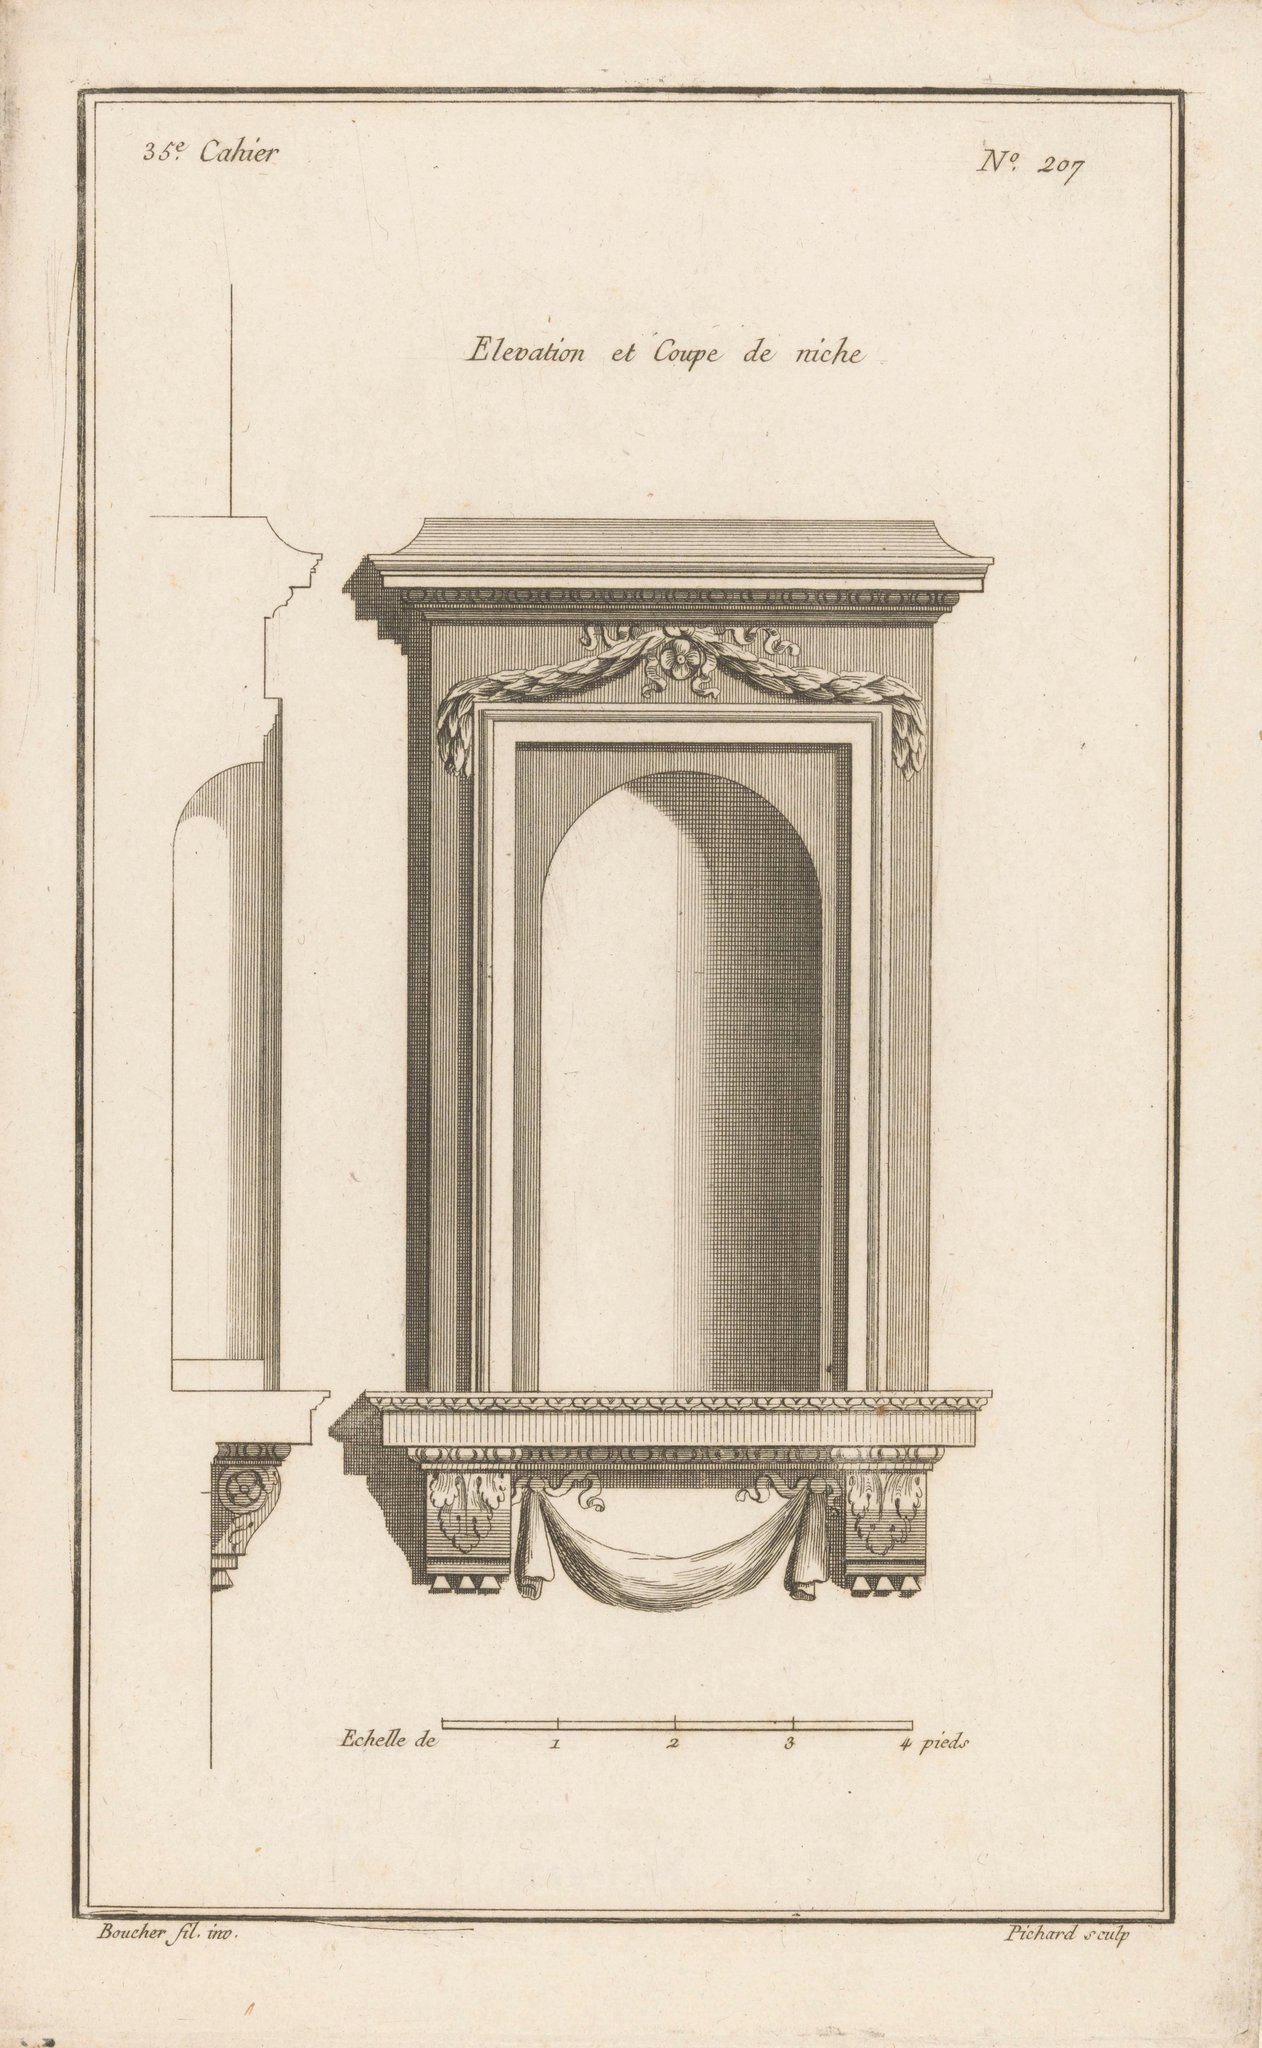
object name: ornament print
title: 35e Cahier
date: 1772-1779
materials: paper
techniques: engraving, etching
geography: paris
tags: 'concha' ~ architecture, hangings and drapery, ornament ~ festoon, garland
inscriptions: collector's mark: Lugt 2760, collector's mark: Lugt 2228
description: Voor- en zijaanzicht van een lege nis met guirlandes en draperie aan de onderzijde. Prentnummer 207.